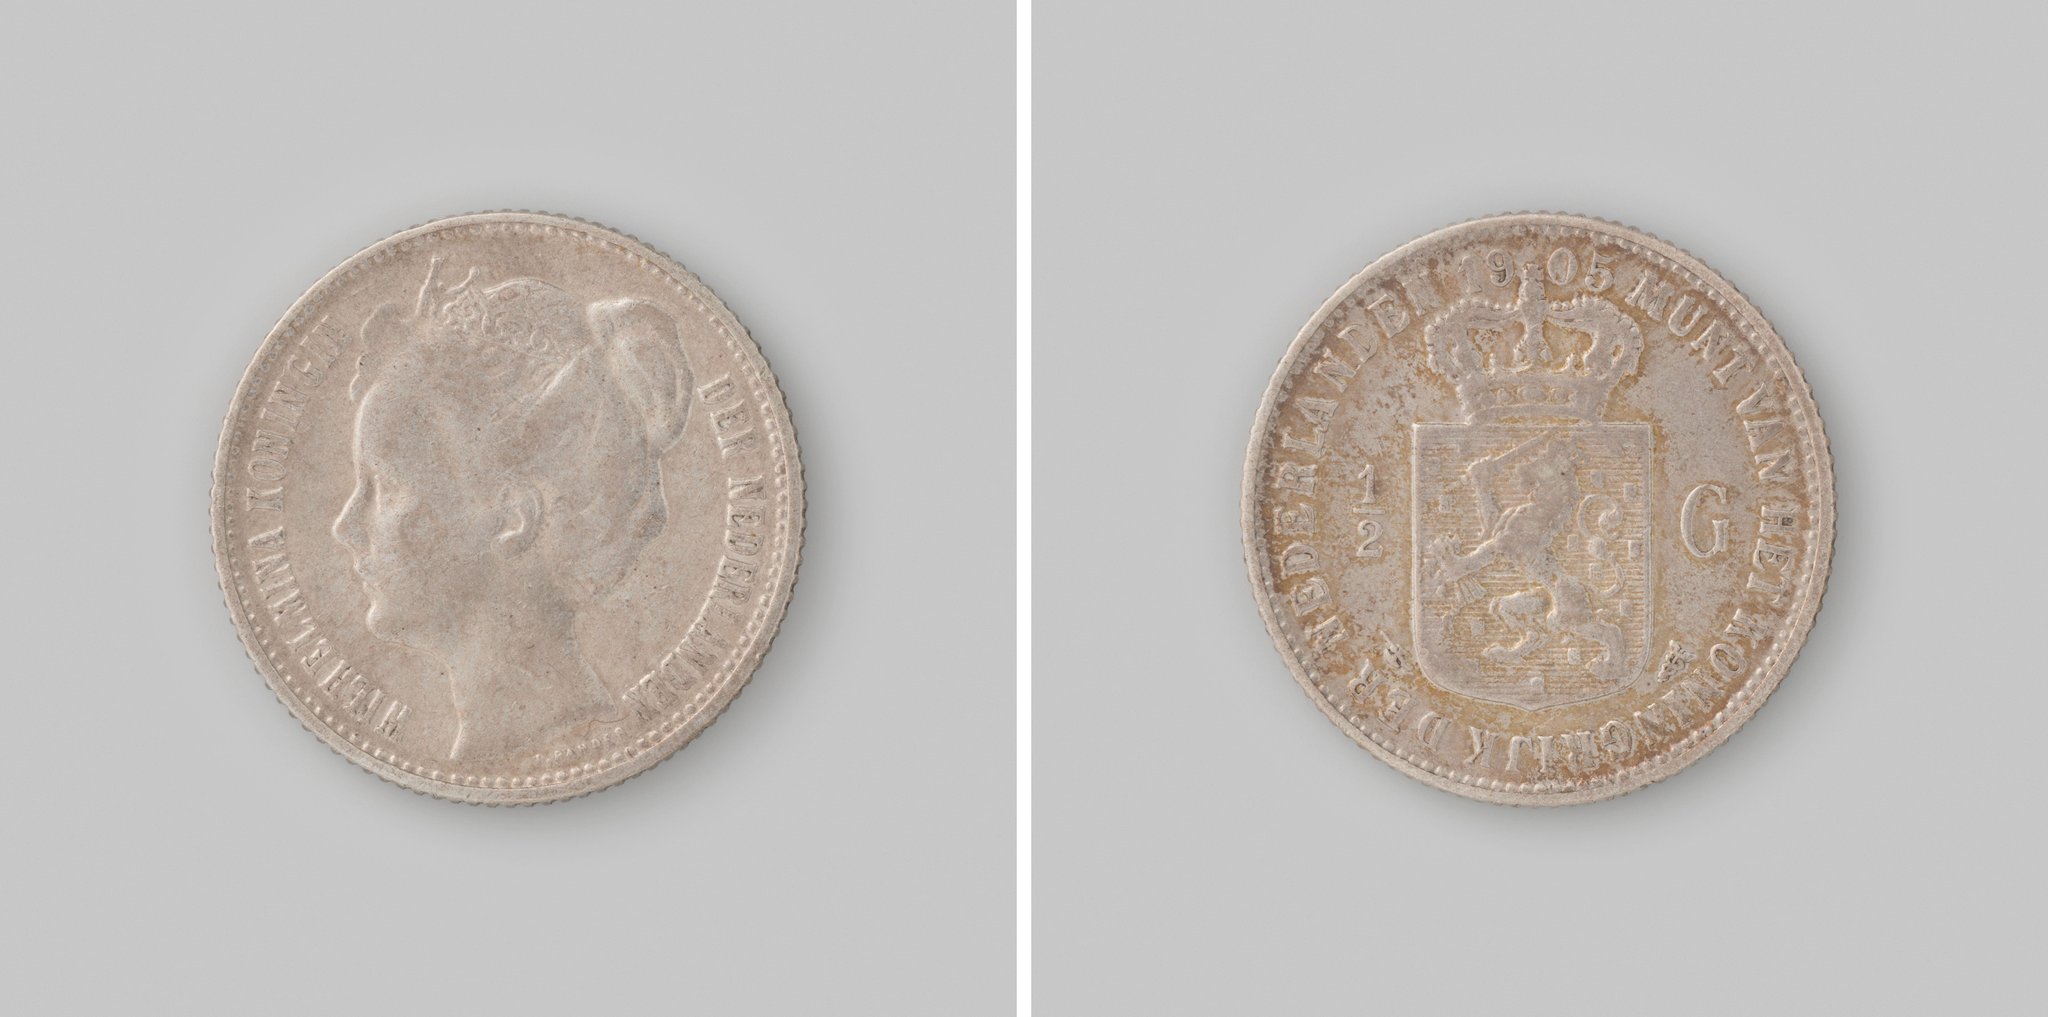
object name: coin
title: Nederland, ½ gulden, 1905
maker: wilhelmina of the netherlands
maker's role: print maker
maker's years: 1880-1962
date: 1905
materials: silver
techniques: striking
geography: utrecht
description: Zilveren munt. Voorzijde: hoofd met diadeem naar links.Keerzijde: tussen waarde-aanduiding ½ G gekroond rijkswapenschild. Jaartal bovenaan in omschrift. Karteland.